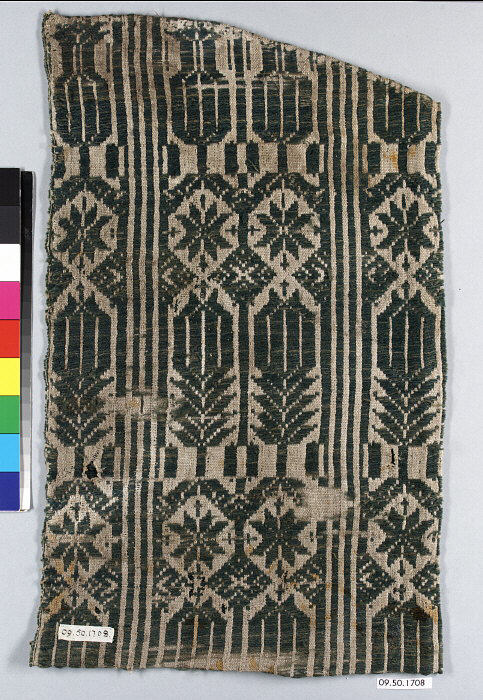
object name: fragment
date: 1601-1800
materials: linen, wool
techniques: weave